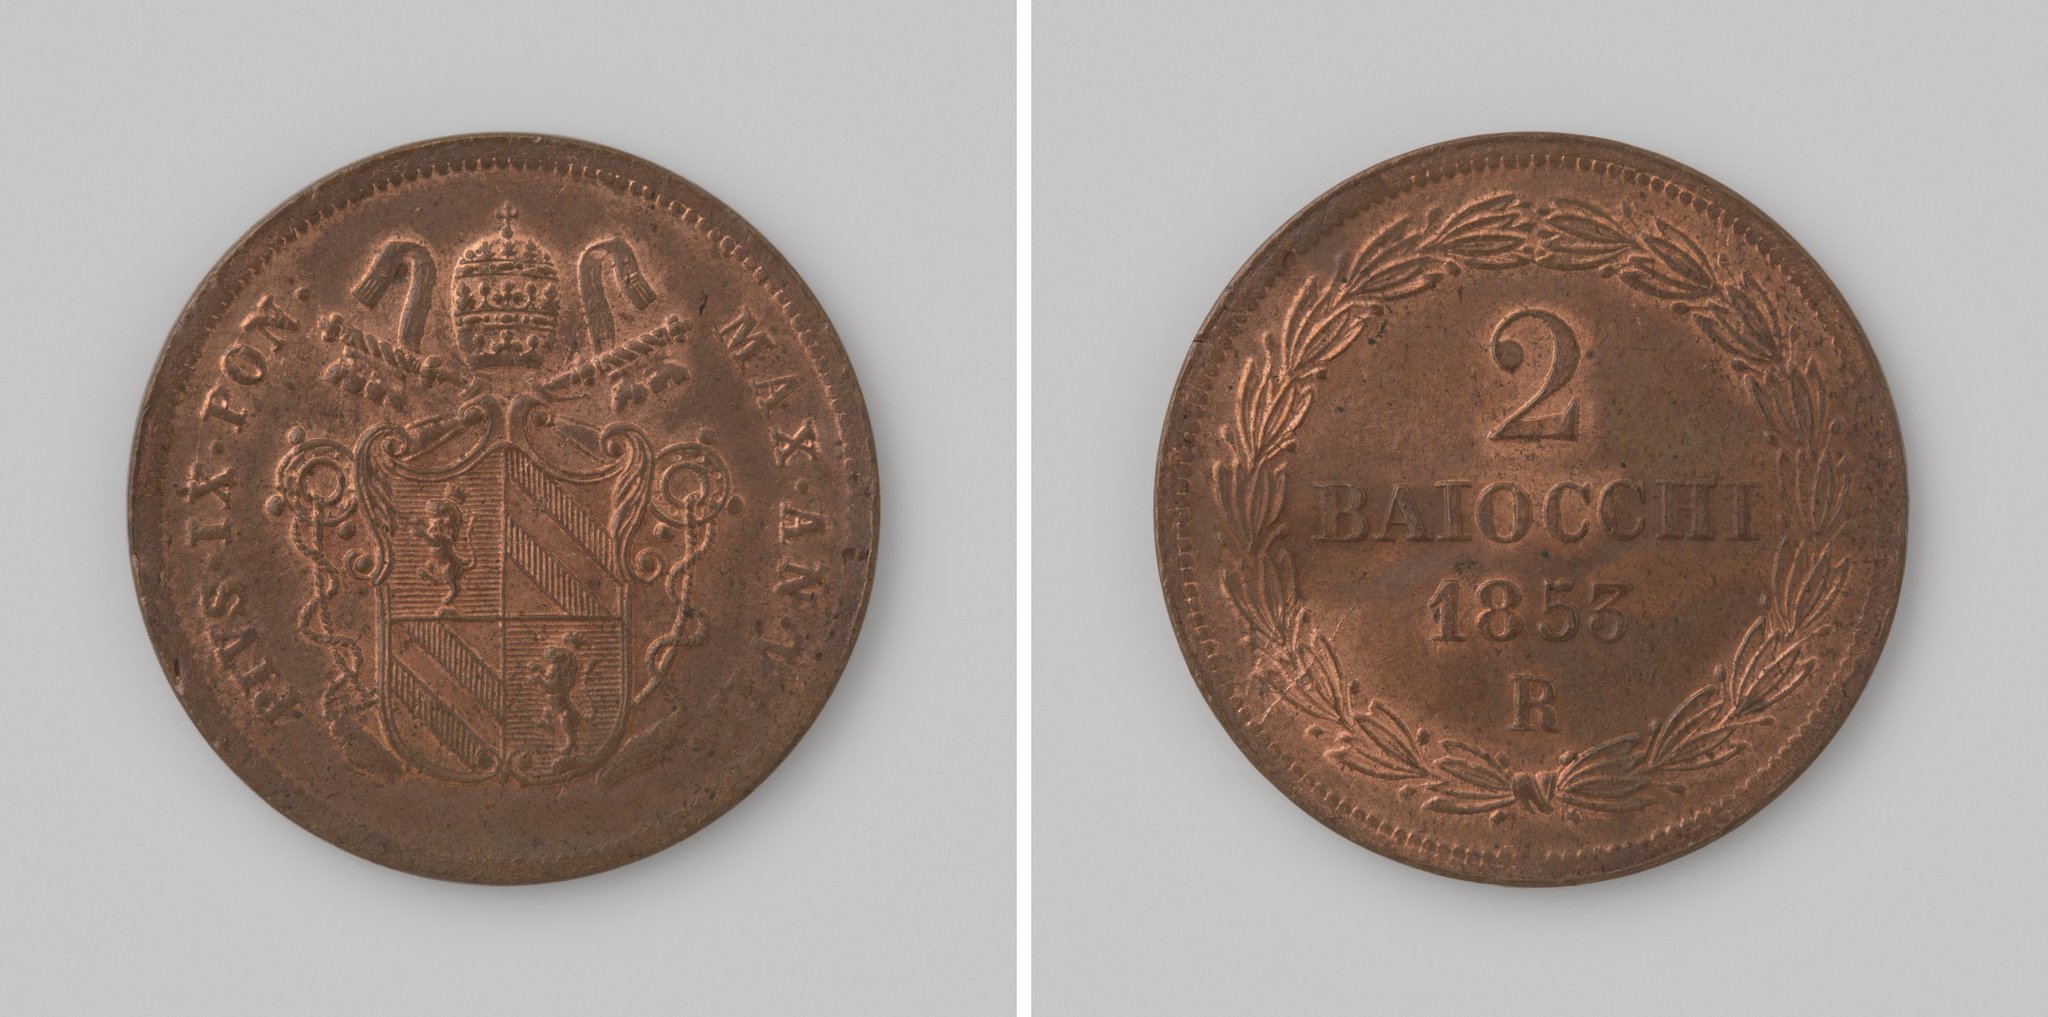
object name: coin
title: 2 baiocchi uit de Kerkelijke Staat van paus Pius IX, 1853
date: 1853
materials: copper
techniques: striking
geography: rome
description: Koperen munt. Voorzijde: versierd wapenschild, waarboven twee gekruiste sleutels. Daarboven tiara. Keerzijde: binnen twee samengebonden takken waarde-aanduiding in twee regels, waaronder jaartal. Daaronder letter R [=Rome]. Gladde rand.